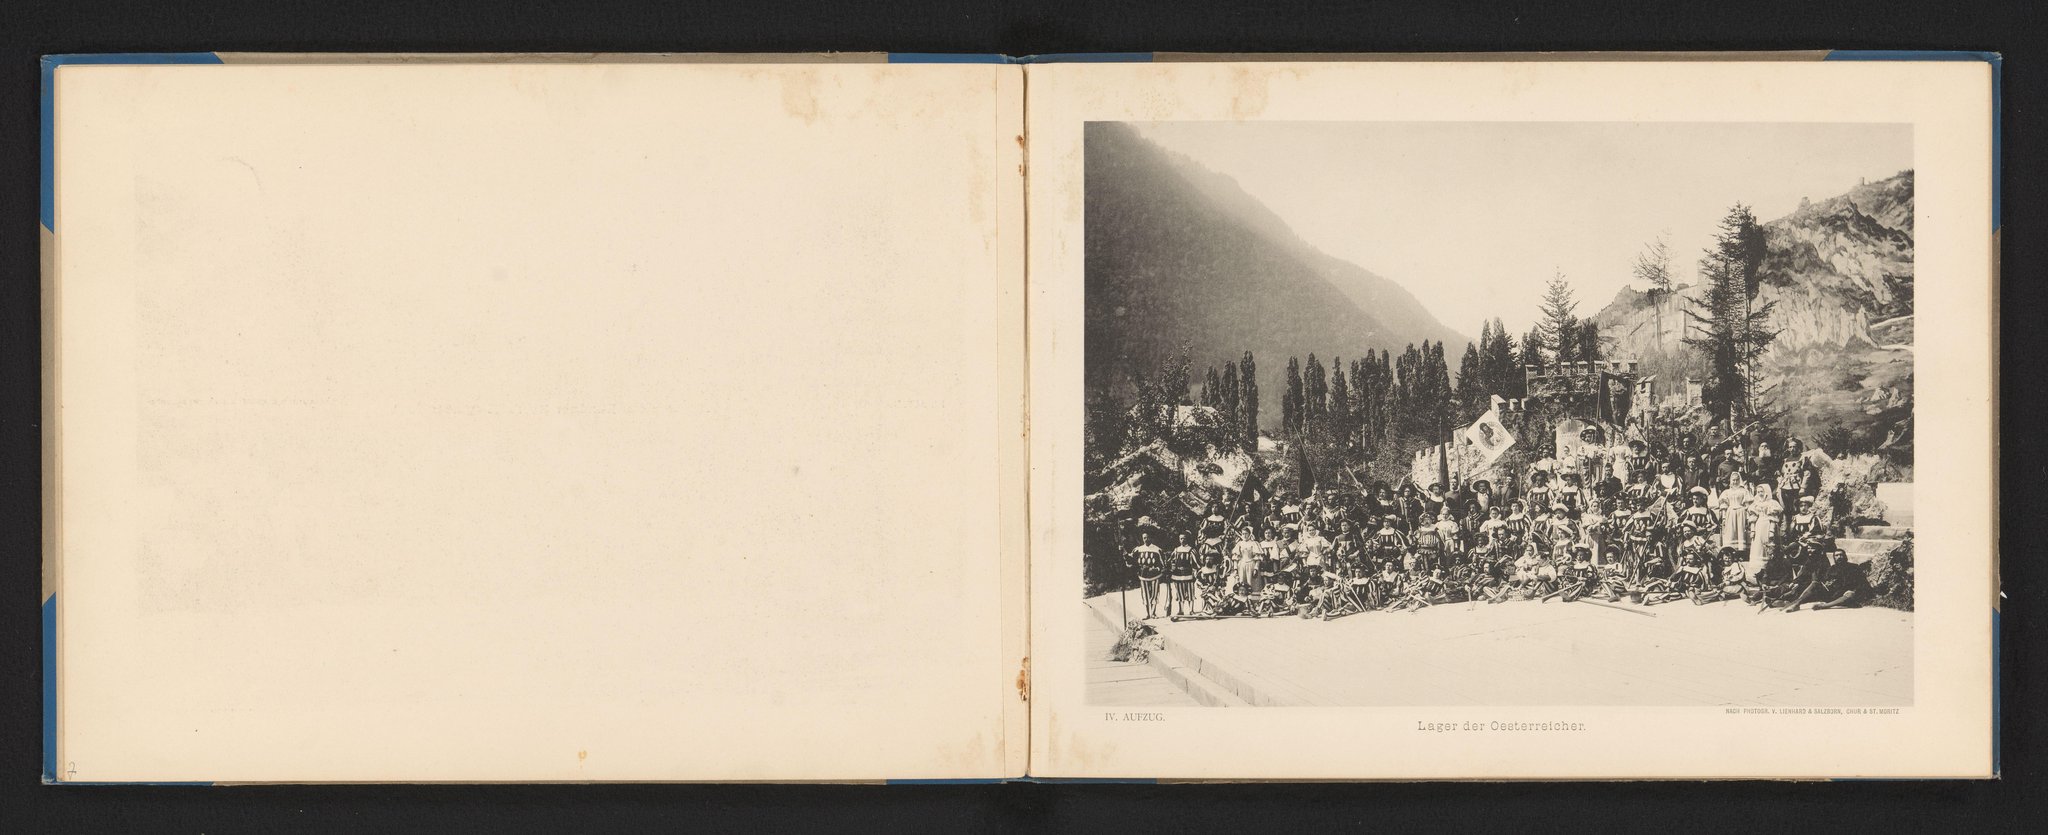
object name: page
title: Lager der Oesterreicher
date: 1898-1899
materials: paper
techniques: photograph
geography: chur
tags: group of actors, troupe; actors on the stage, anonymous historical persons portrayed in a group, in a group-portrait, mountains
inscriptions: number: ‘IV.’